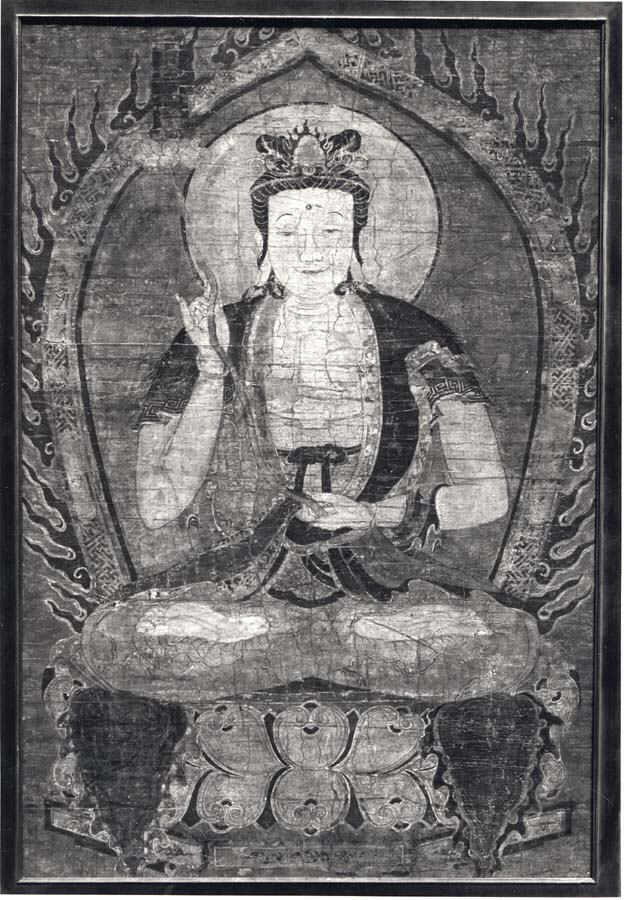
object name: painting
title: Seated Boddhisattva, Tara, on Lotus Throne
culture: chinese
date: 1401-1500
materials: ink, paper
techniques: painting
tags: lotuses,buddhism,bodhisattvas